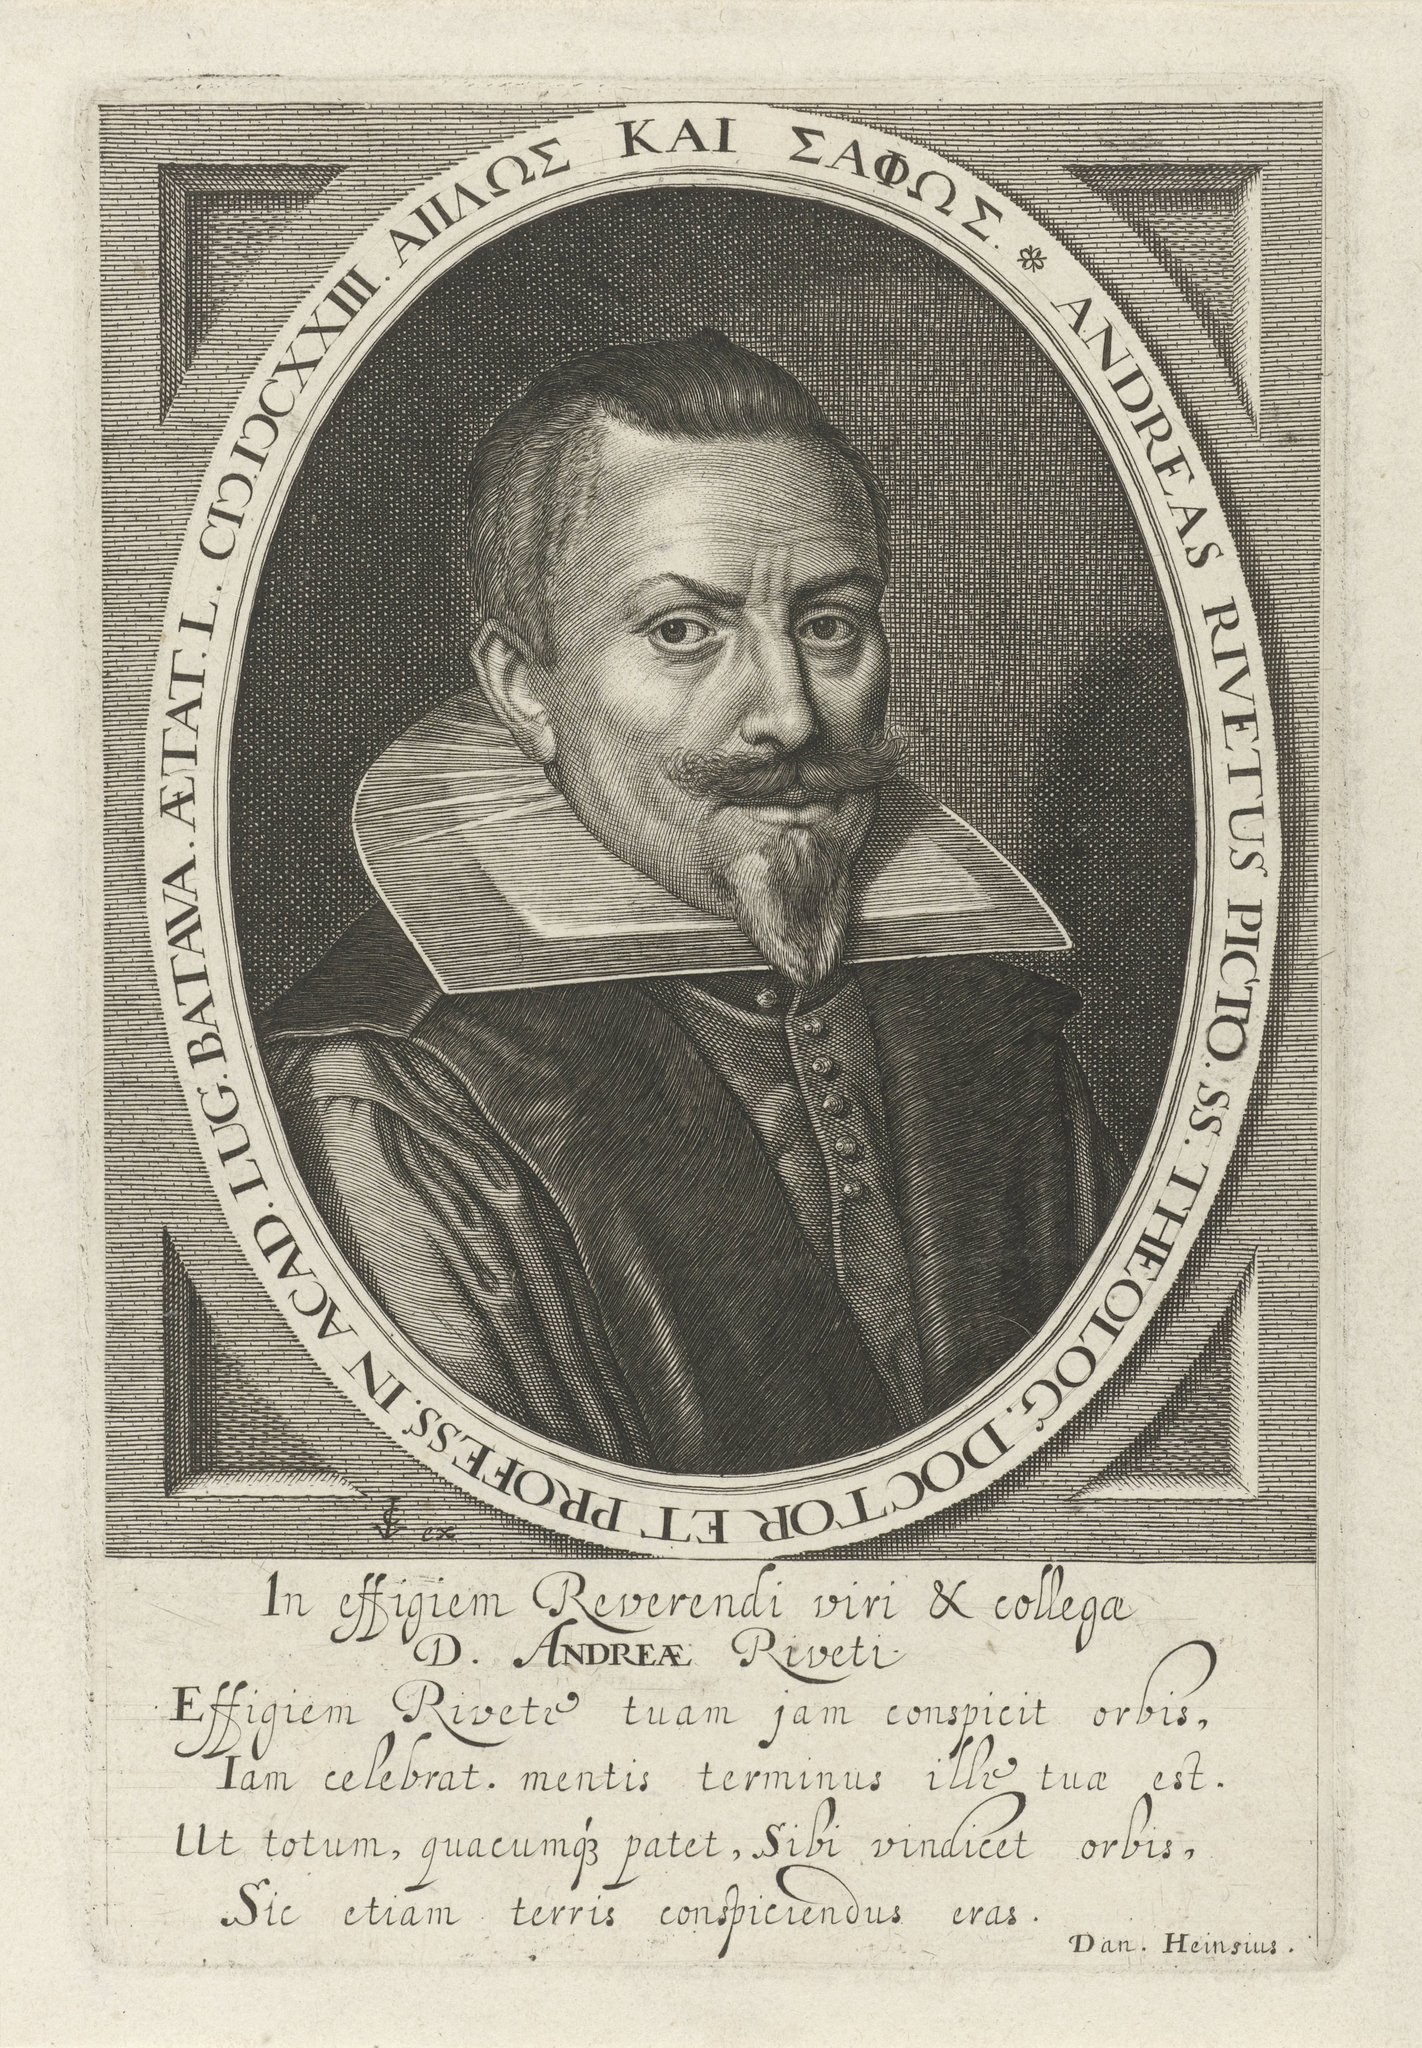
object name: print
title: Portret van André Rivet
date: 1644-1652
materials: paper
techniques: engraving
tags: andré rivet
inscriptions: collector's mark: Lugt 2228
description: Portret van André Rivet, professor honorarius theologie aan de universiteit van Leiden en gouverneur van Prins Willem II. In de marge een vers in het Latijn.